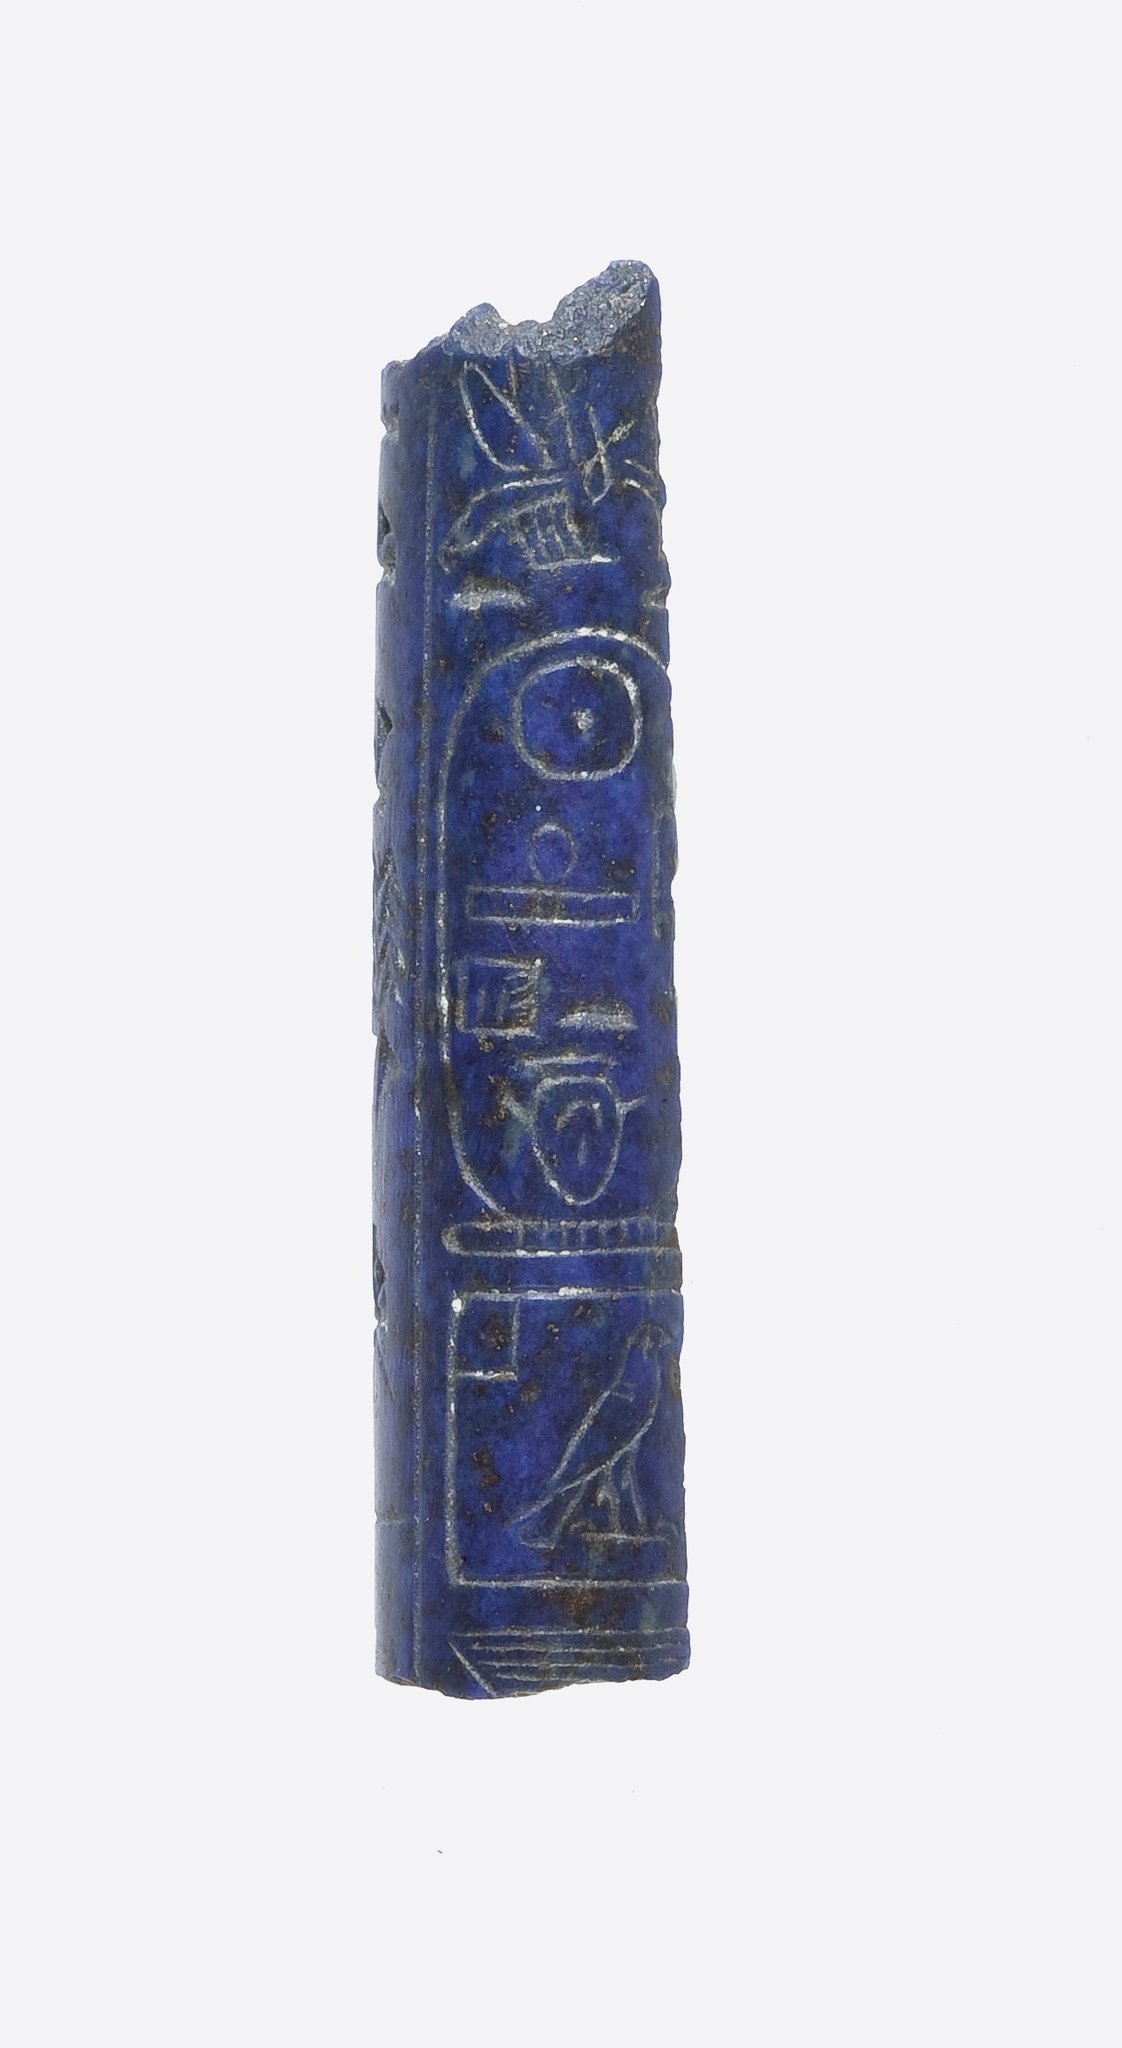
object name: cylinder seal, bilingual, sehetepibre ii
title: Bilingual Cylinder Seal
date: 1782-1780 BCE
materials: lapis lazuli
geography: egypt